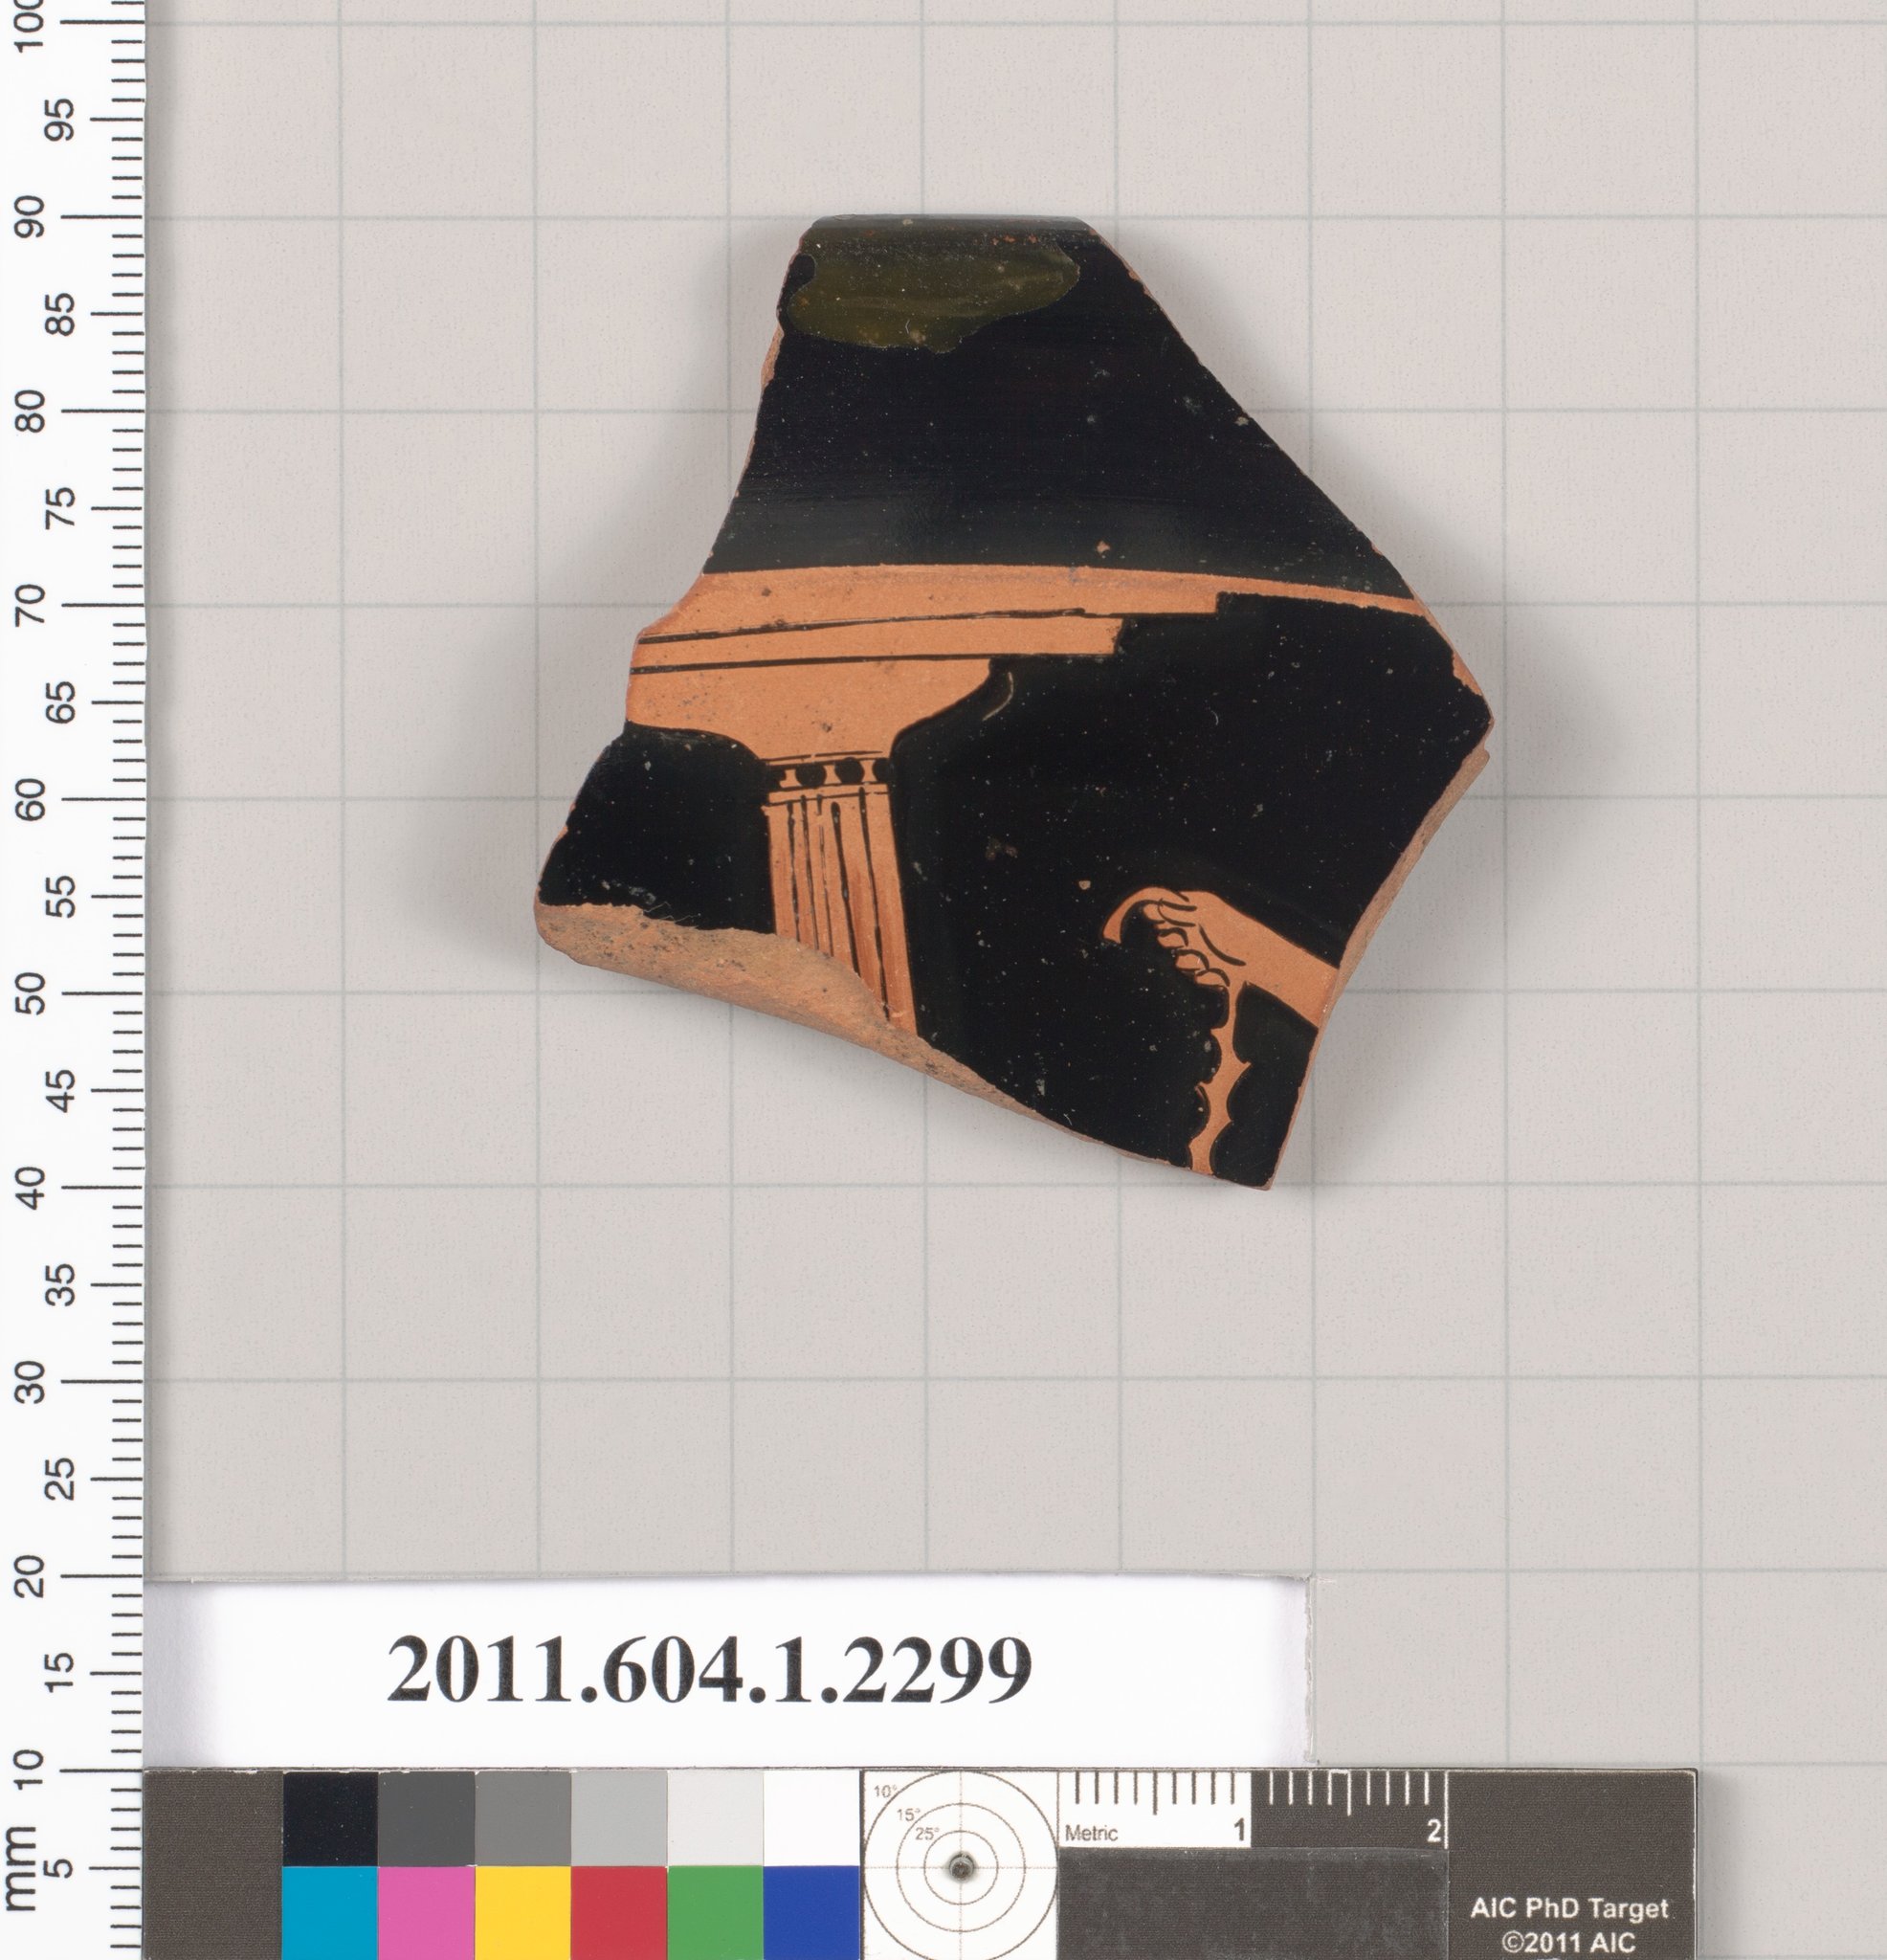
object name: kylix fragment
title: Terracotta rim fragment of a kylix (drinking cup)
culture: greek, attic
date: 490-480 BCE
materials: terracotta